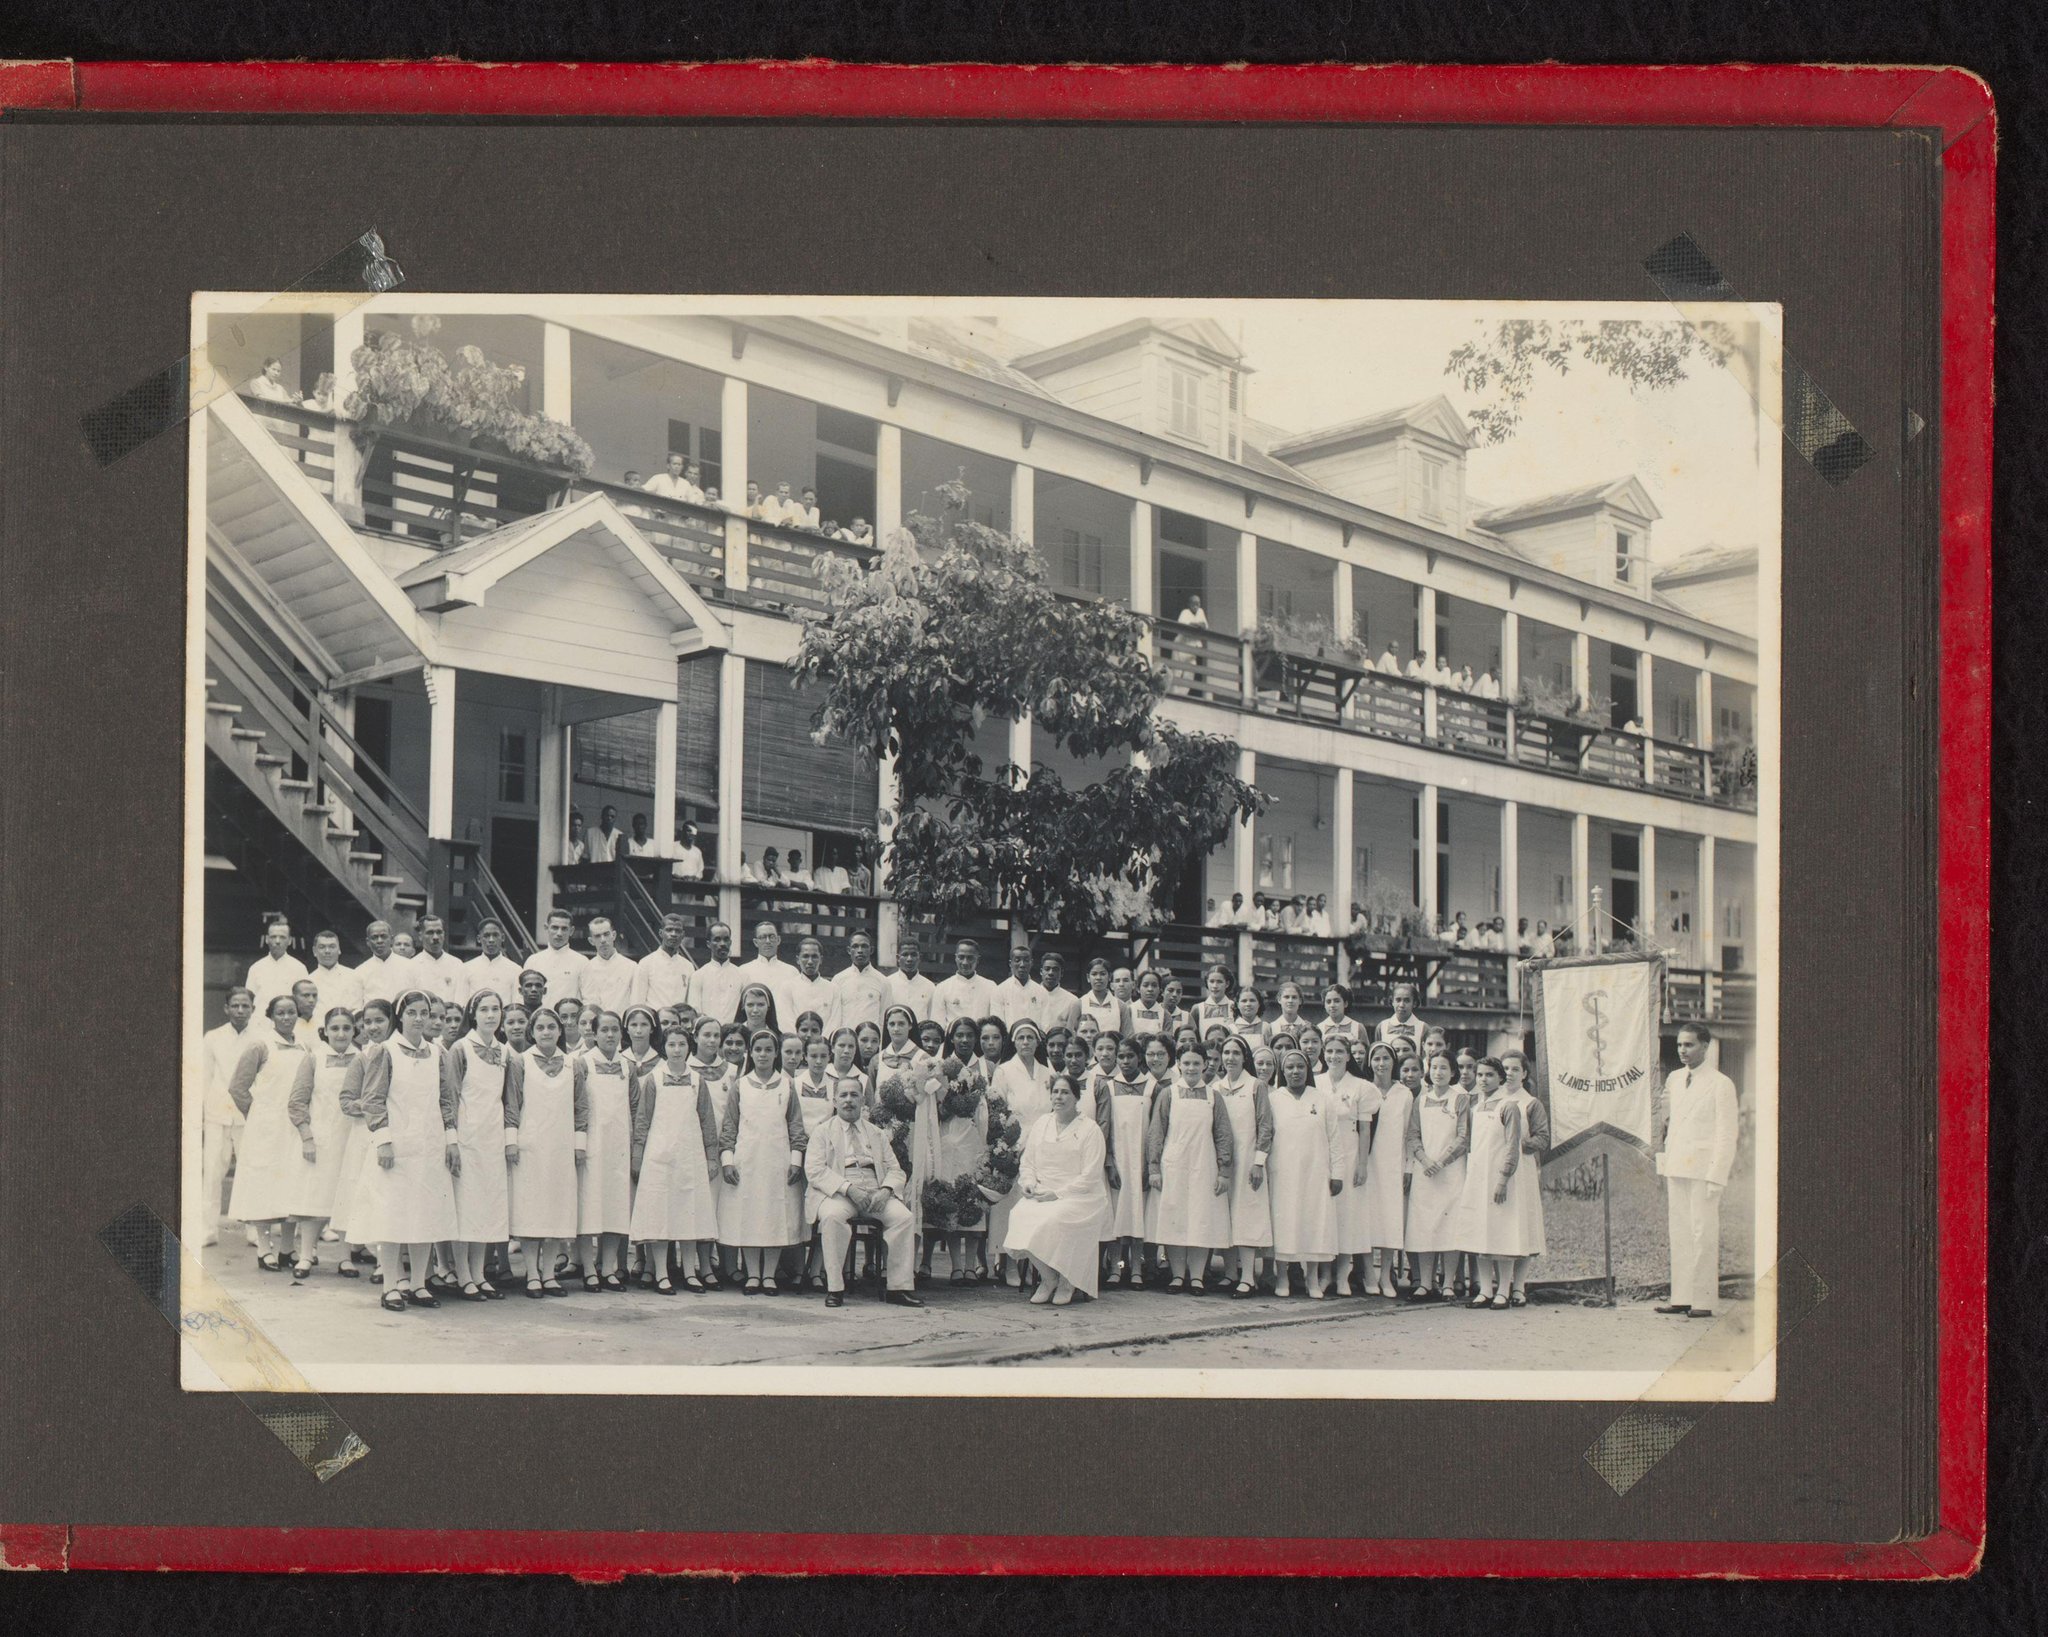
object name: album leaf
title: 's Lands Hospitaal, Paramaribo, Suriname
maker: Anonymous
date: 1934-1935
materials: paper, photographic support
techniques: gelatin silver print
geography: paramaribo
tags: hospital, anonymous historical persons portrayed in a group, in a group-portrait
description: Groepsfoto uit fotoalbum van ziekhuispersoneel voor het gebouw van 's Lands Hospitaal in Paramaribo, Suriname. Rechts een man met een banier met de naam van het ziekenhuis. Onderdeel van het fotoalbum van Theodoor Brouwers over Suriname ca. 1930.